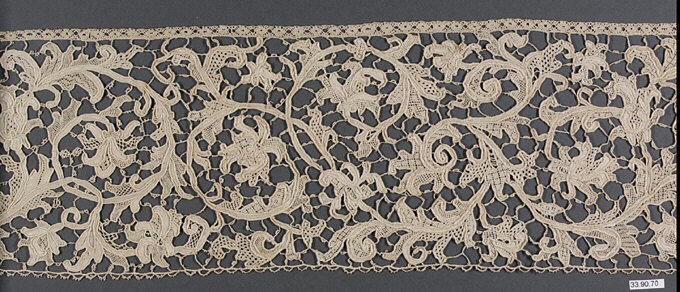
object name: border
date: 1601-1700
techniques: lace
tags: flowers